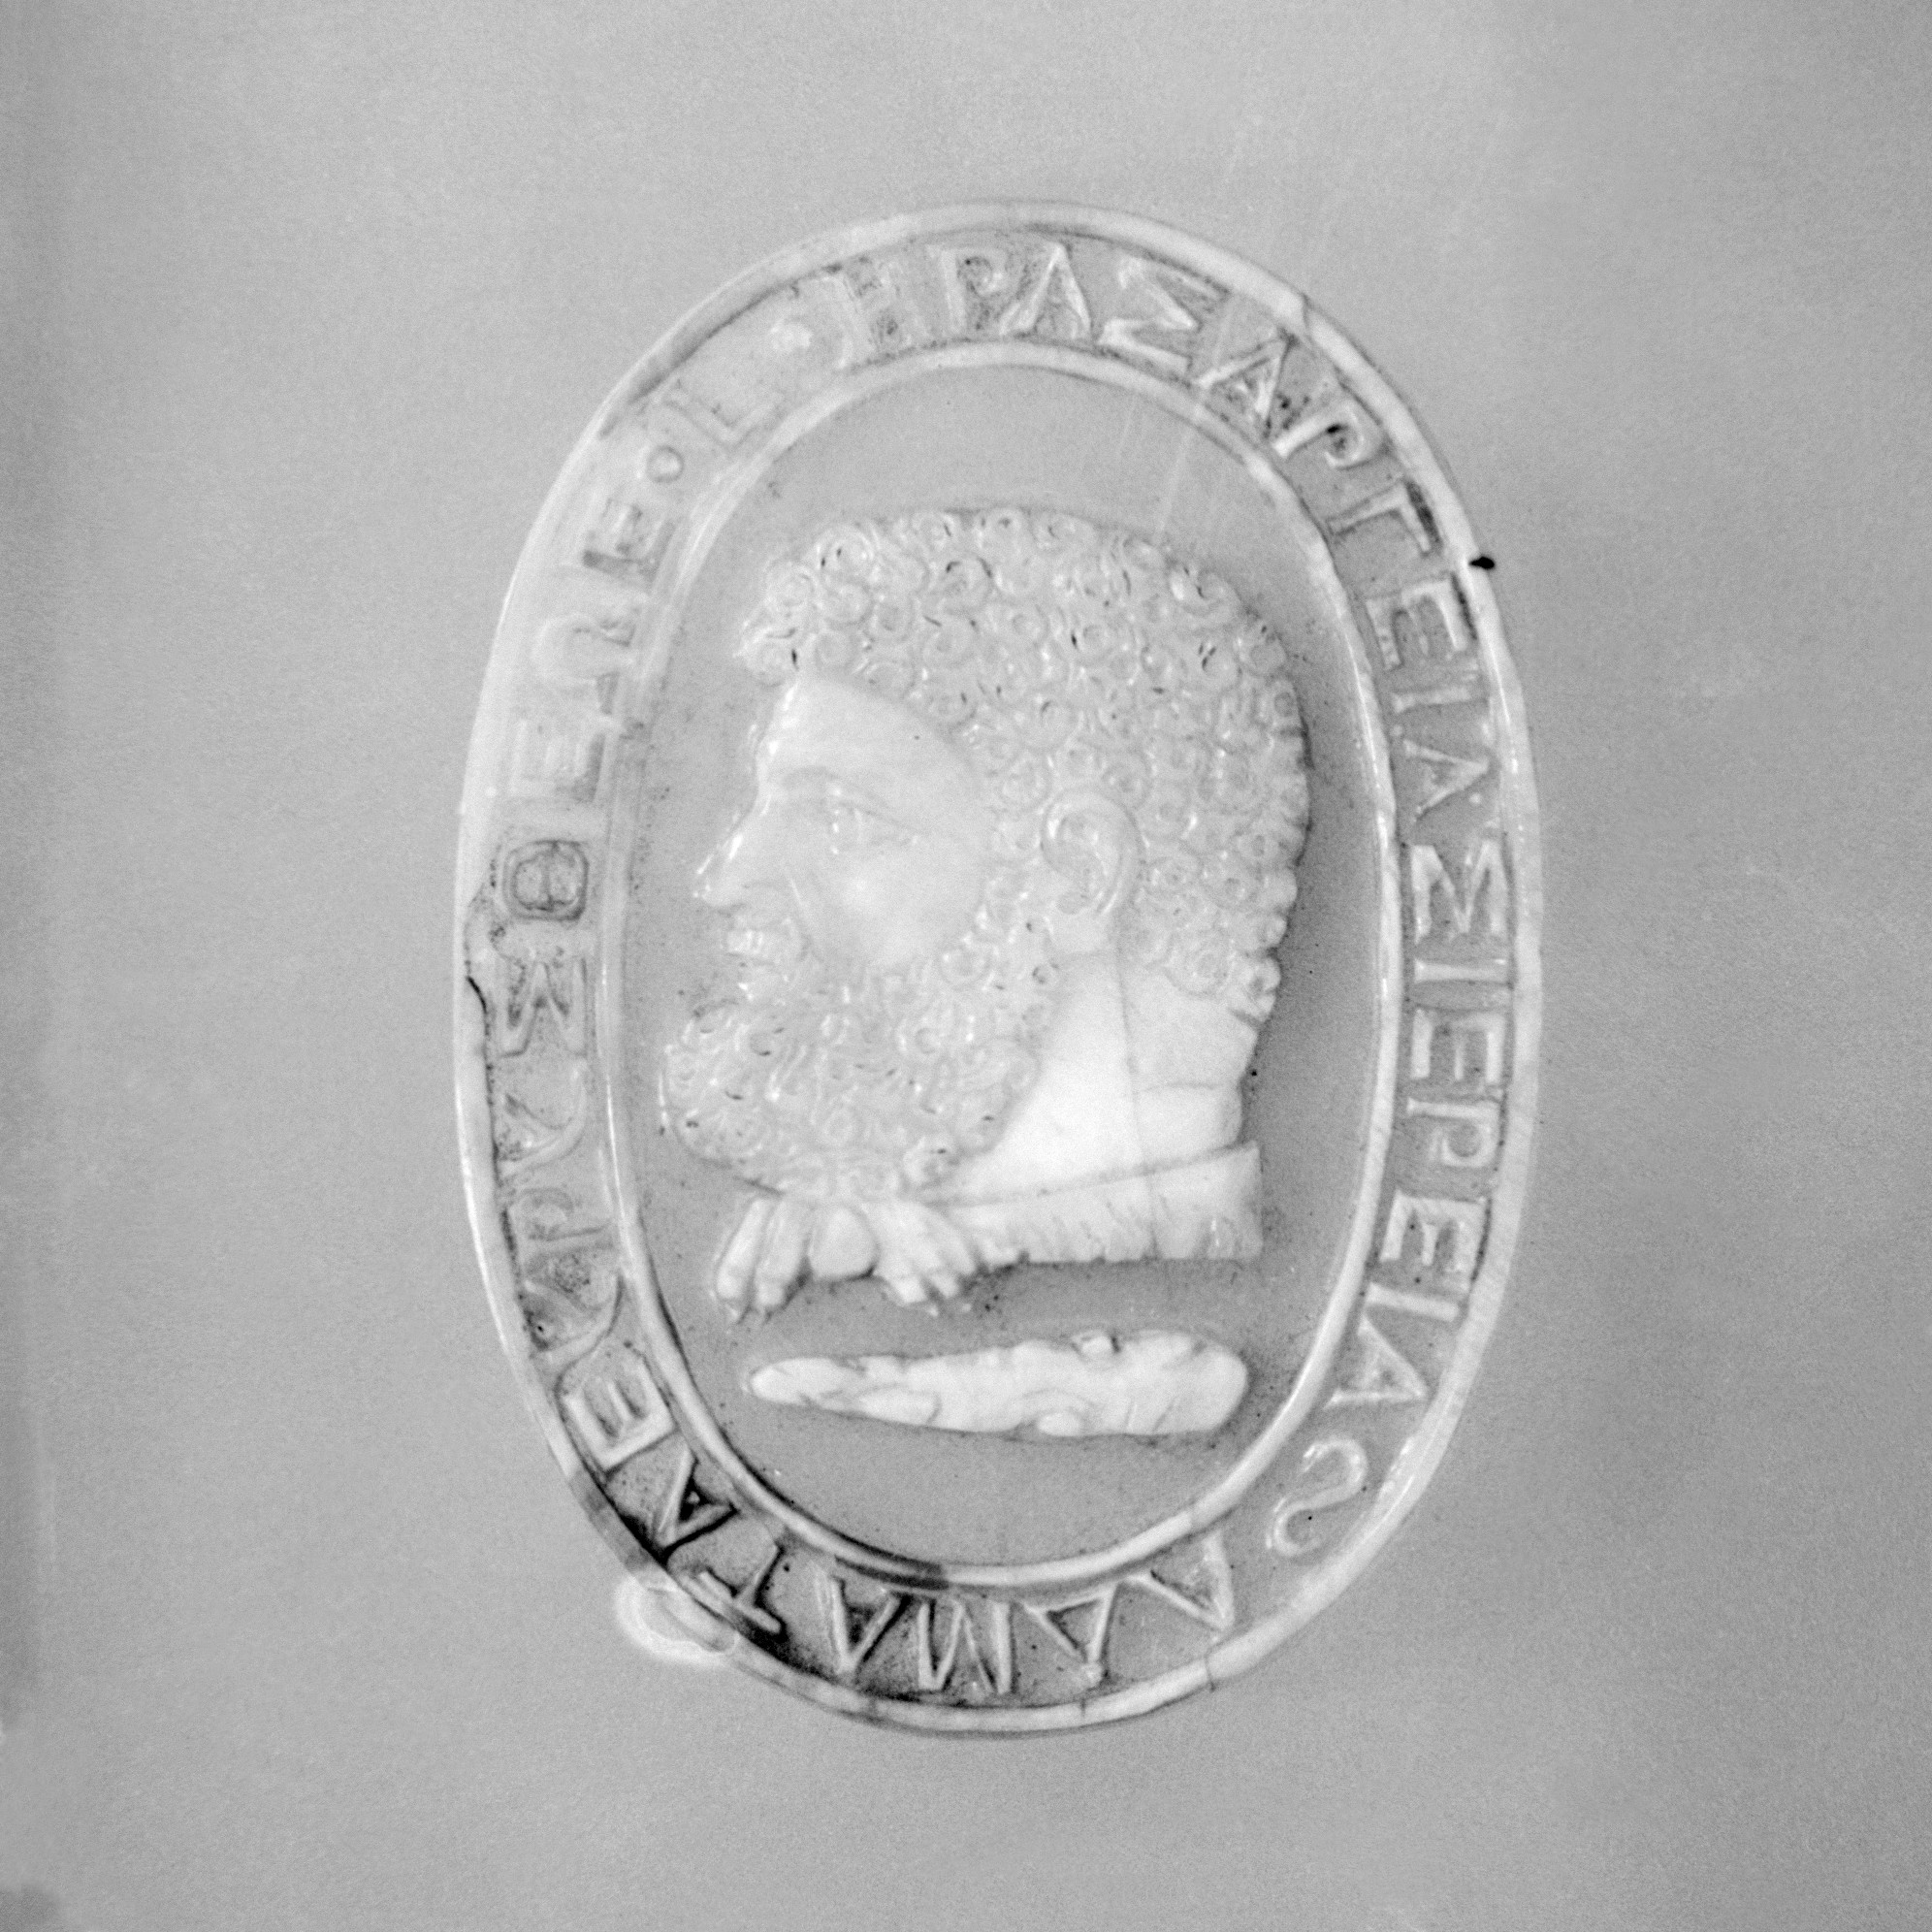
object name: cameo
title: Head of Hercules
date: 1501-1700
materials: onyx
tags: heads,profiles,hercules